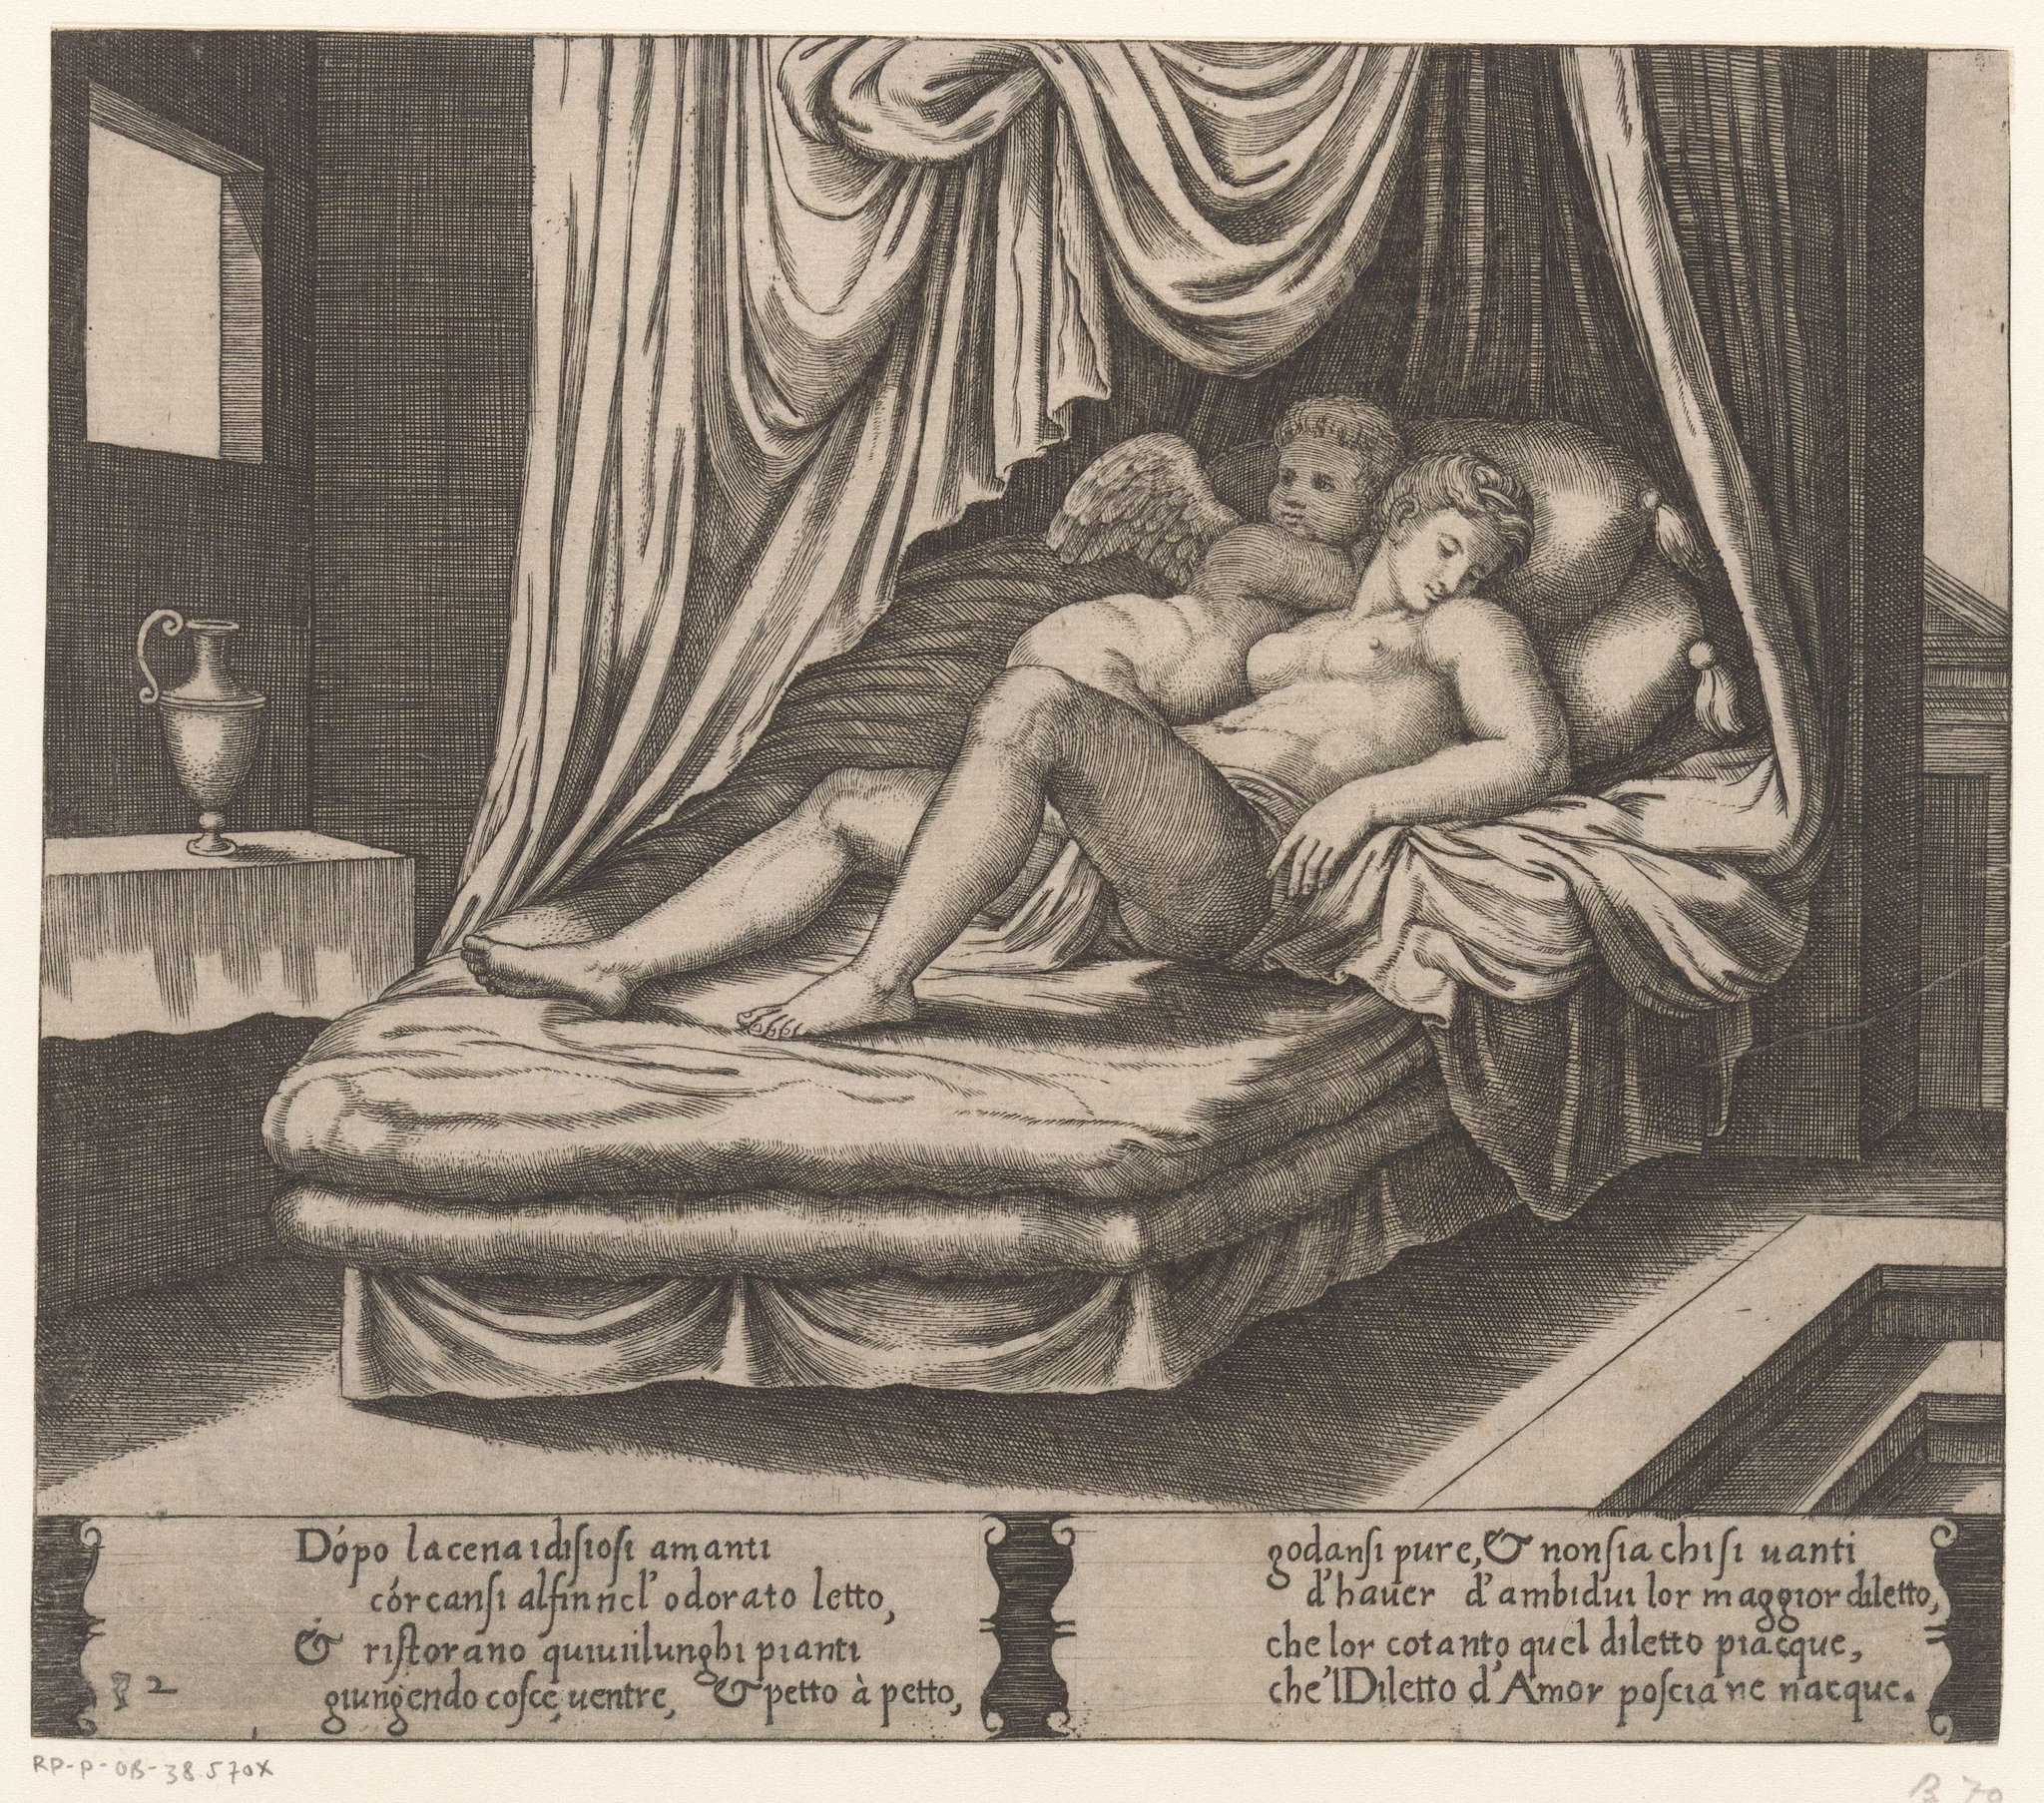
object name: print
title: Verhaal van Amor en Psyche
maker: meester van de dobbelsteen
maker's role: print maker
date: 1530-1560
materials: paper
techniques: engraving, intaglio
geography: italy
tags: cupid and psyche as lovers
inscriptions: collector's mark: Lugt 2228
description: Amor en Psyche liggen in het huwelijksbed. Terwijl Psyche ligt te slapen, kijkt Amor uit het open raam links. Italiaanse tekst in twee cartouches in ondermarge. Genummerd linksonder: 32.